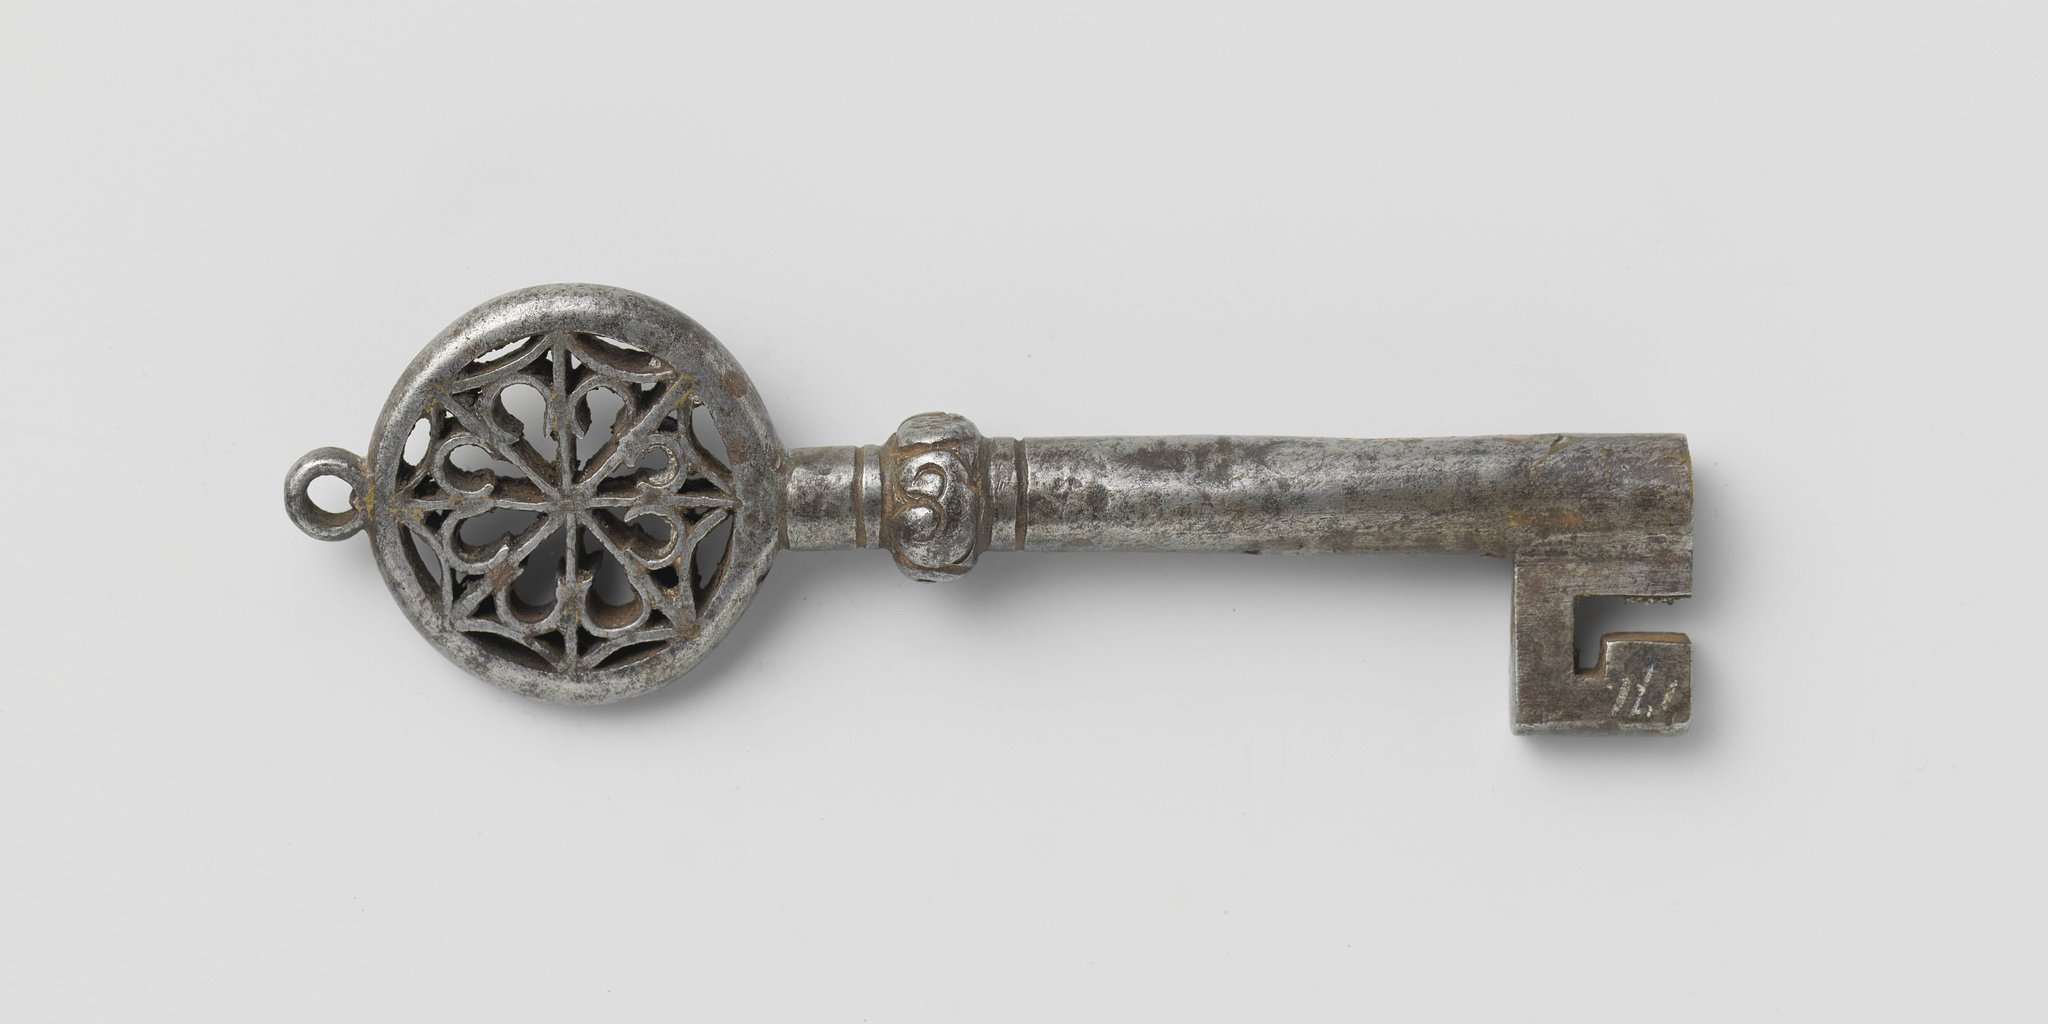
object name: pipe key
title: Venetian key with barrel shank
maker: Anonymous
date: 1500-1600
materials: iron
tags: ornament ~ tracery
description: Pijpsleutel zgn. "Venetiaansche sleutel" met roos in de ronde greep, bekroond door een oogje. De schacht wordt onderbroken door geciseleerde nodus en is onderaan gebarsten.